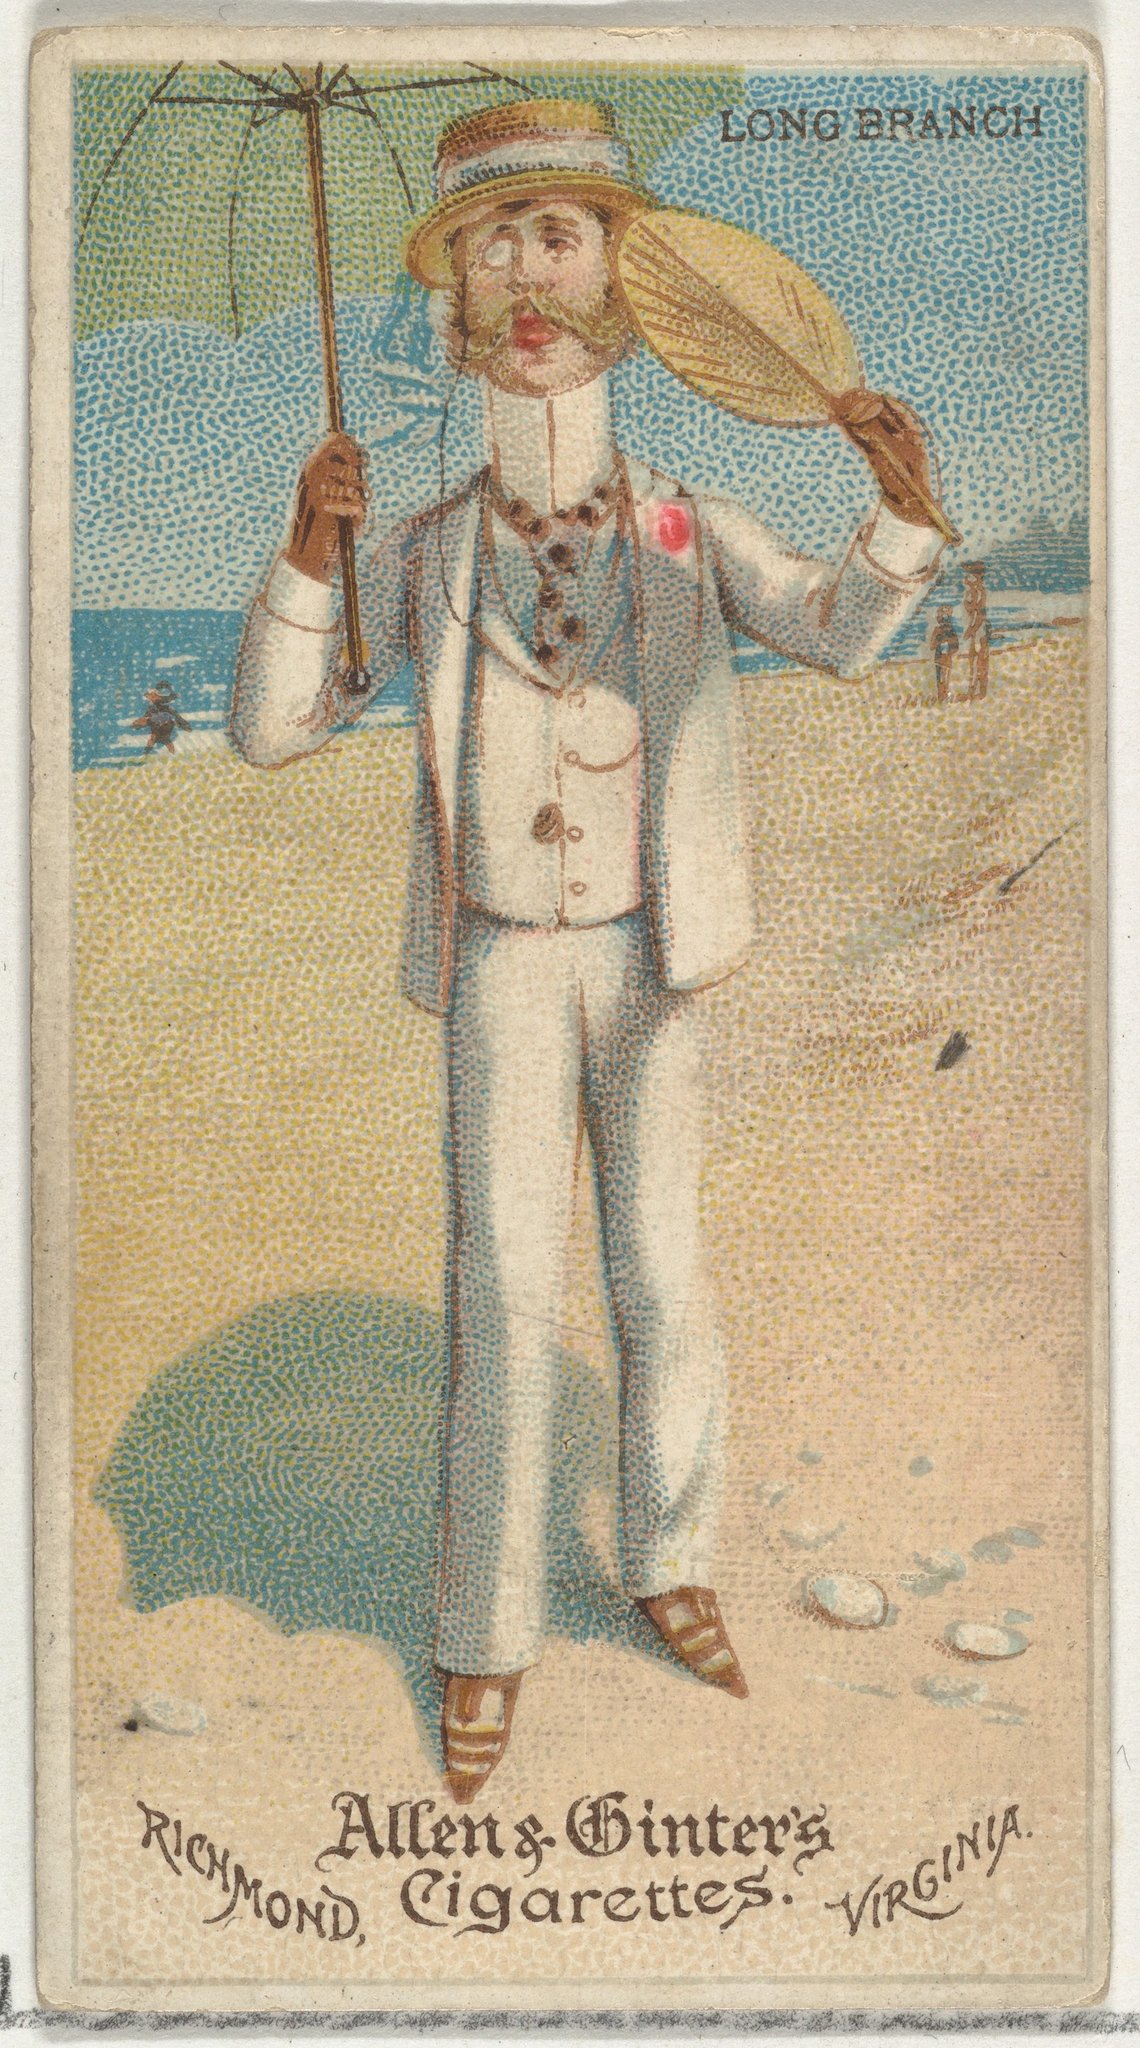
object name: print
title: Long Branch, from World's Dudes series (N31) for Allen & Ginter Cigarettes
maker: allen & ginter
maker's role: publisher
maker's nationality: american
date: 1888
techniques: color lithograph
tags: men,beaches